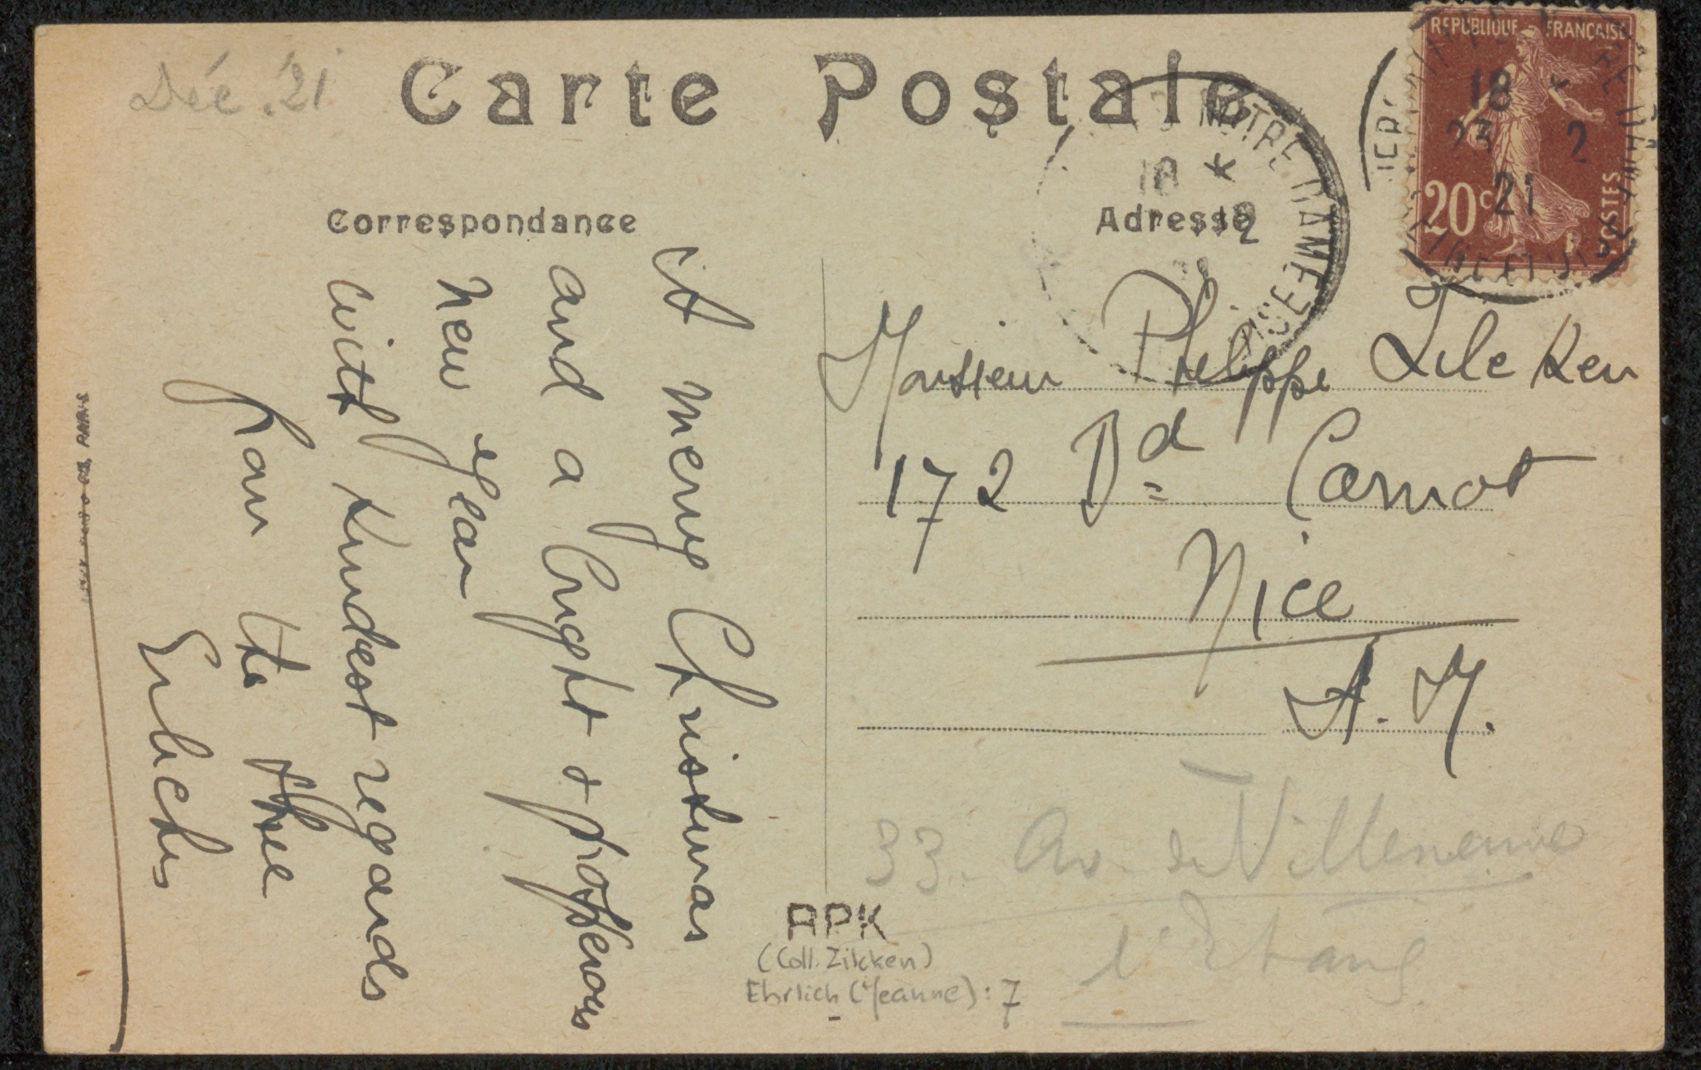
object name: ansichtkaart, prentbriefkaart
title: Prentbriefkaart aan Philip Zilcken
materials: cardboard, ink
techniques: photograph, pen, writing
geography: versailles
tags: the hague, painter, draughtsman, philip zilcken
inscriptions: collector's mark: ‘RPK’